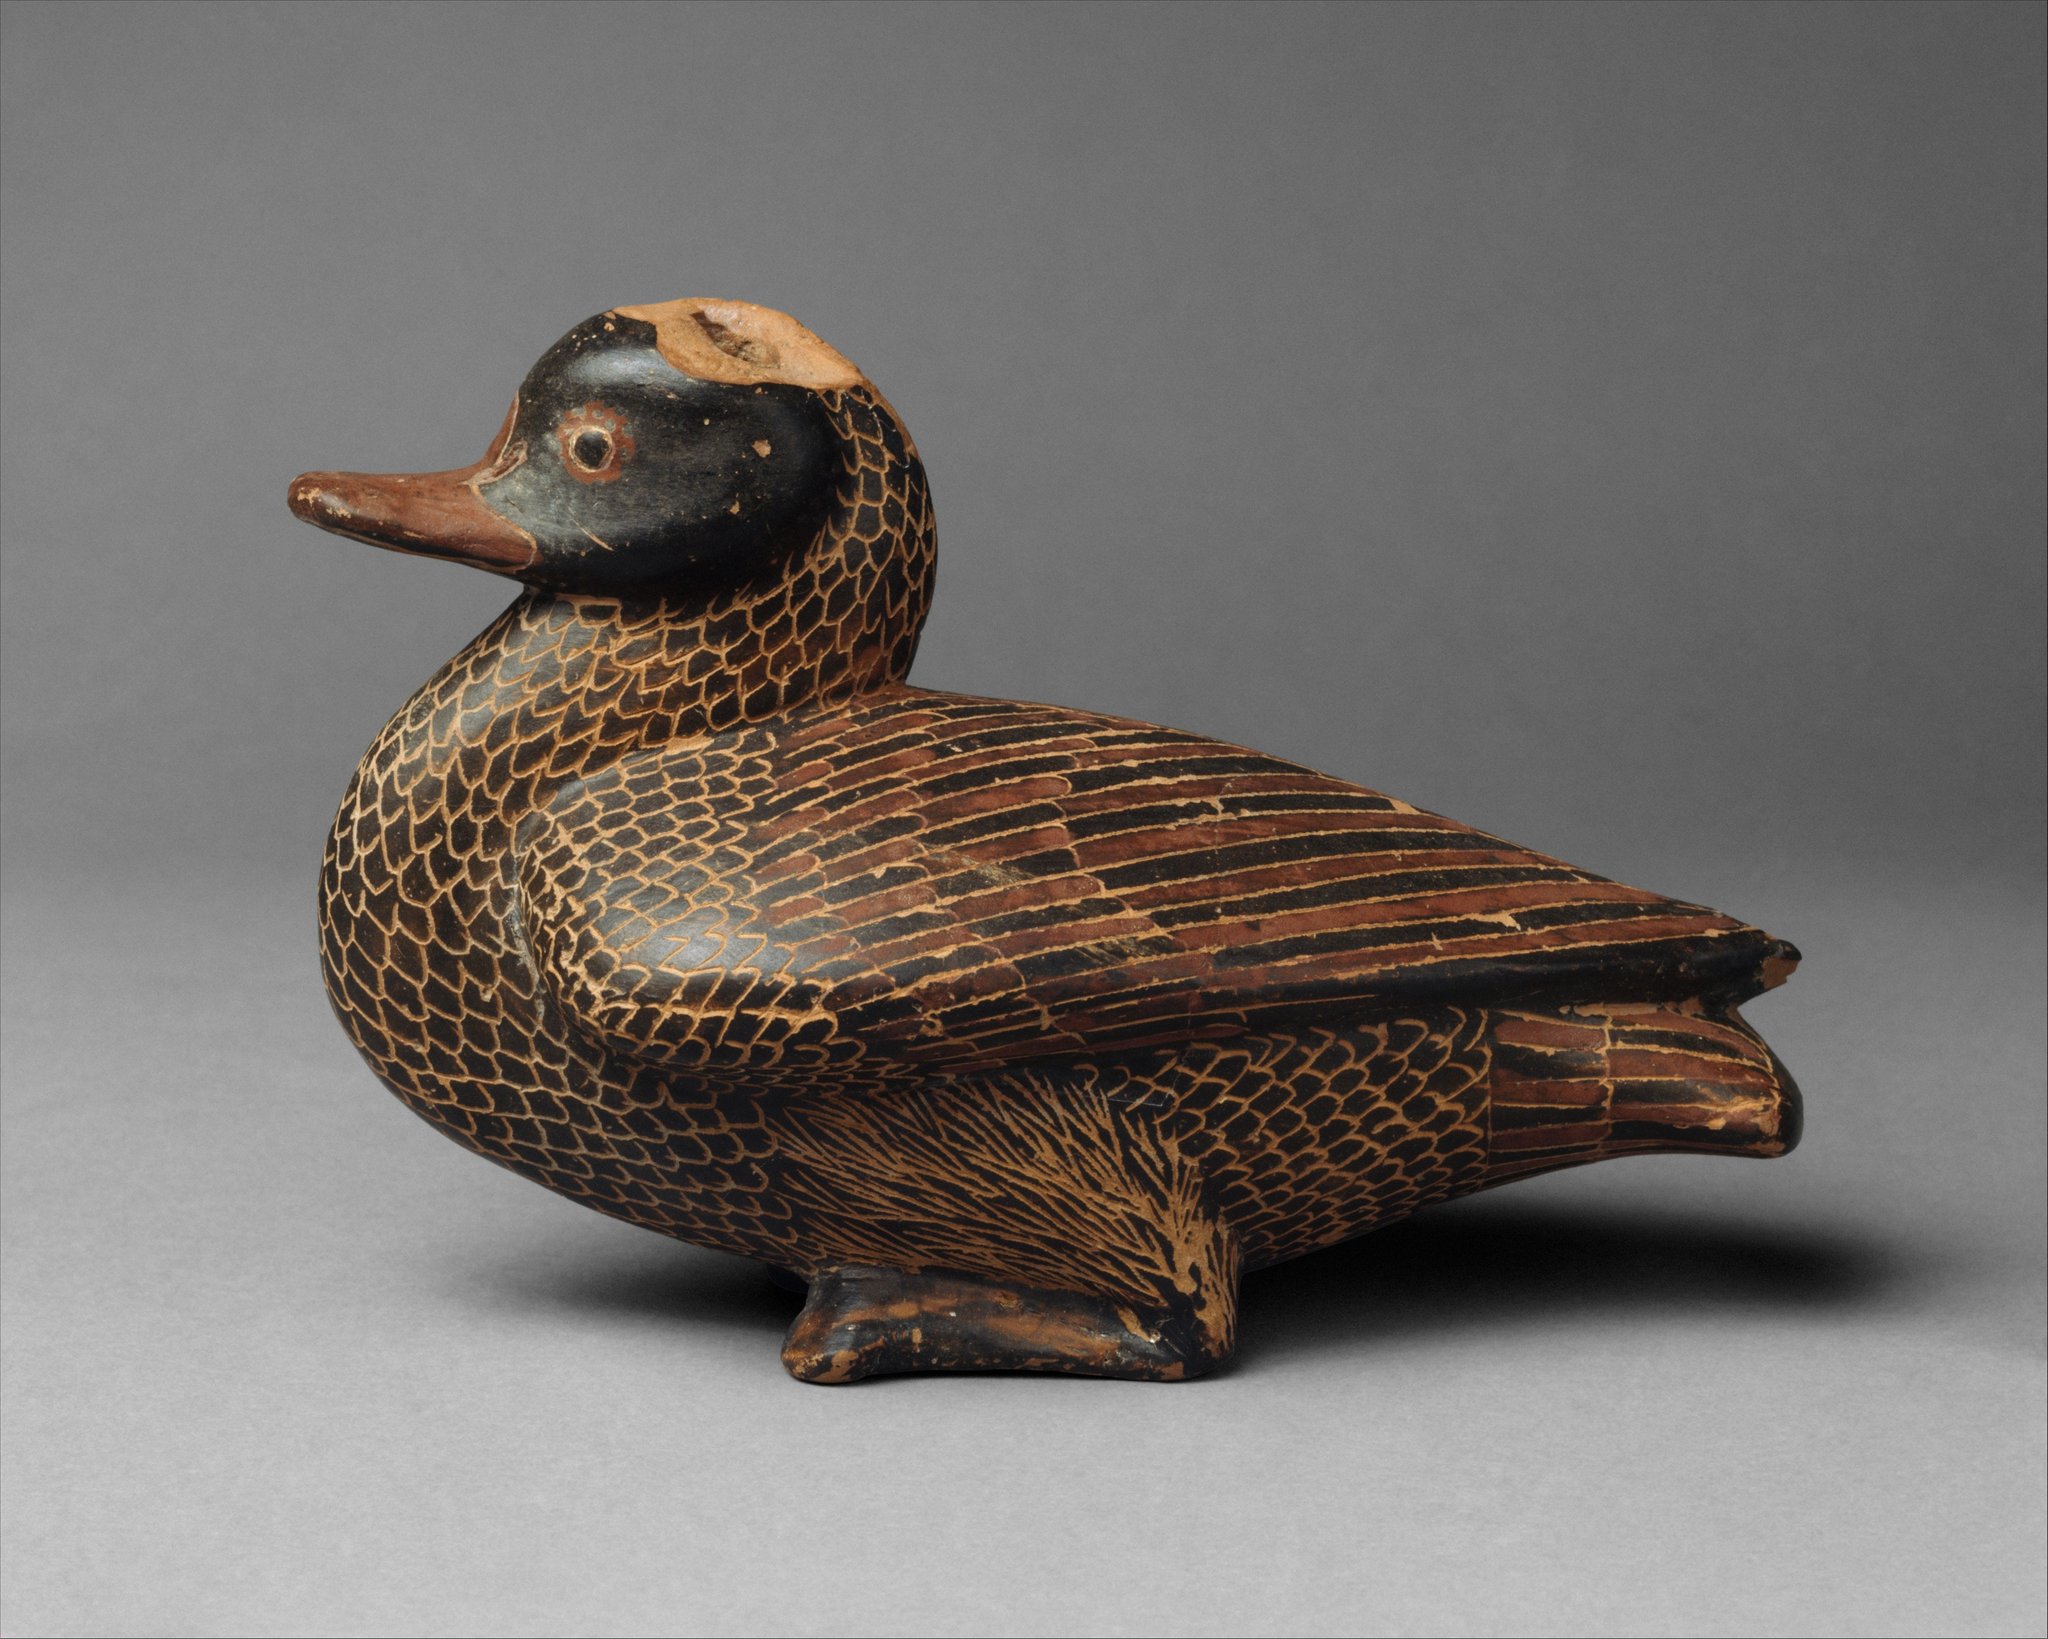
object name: vase in the form of a duck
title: Terracotta vase in the form of a duck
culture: east greek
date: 567-535 BCE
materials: terracotta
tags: ducks